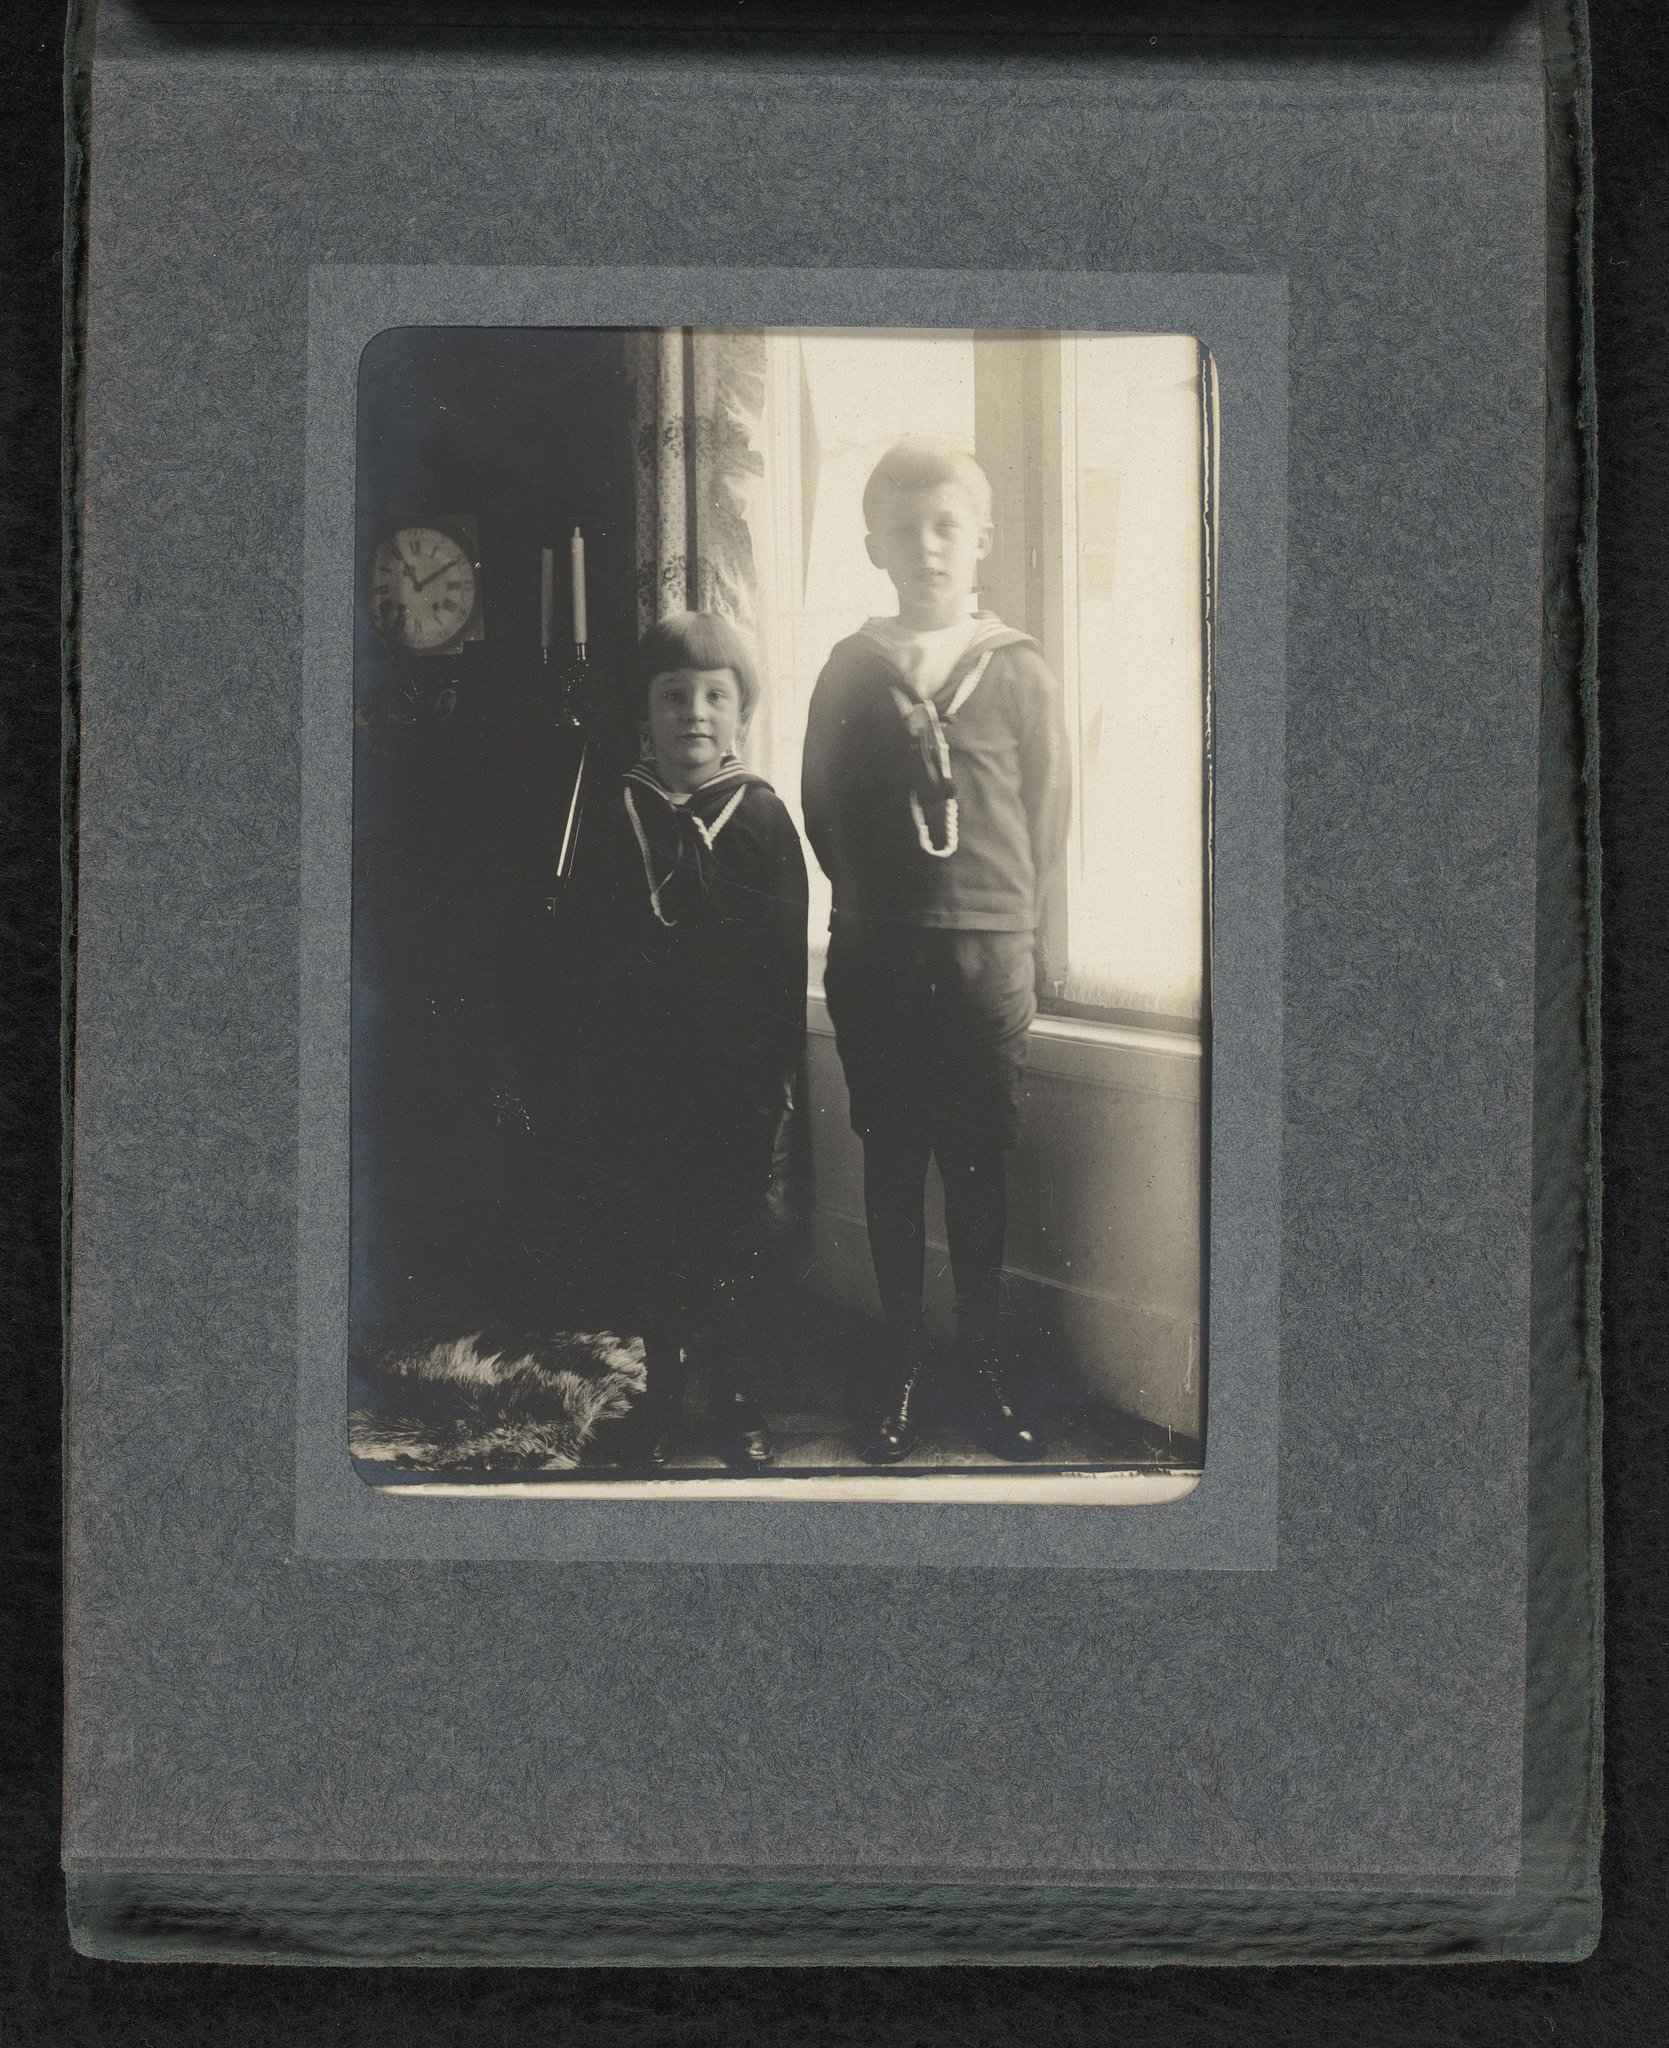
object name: photograph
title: Carel en Frank van den Berg voor een venster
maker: hendrik herman van den berg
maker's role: amateurfotograaf, jurist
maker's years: 1875-1944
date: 1918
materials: paper, cardboard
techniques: gelatin silver print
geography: amsterdam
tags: carel frederik van den berg (cay), amsterdam, frank willem van den berg (1912-1998), window